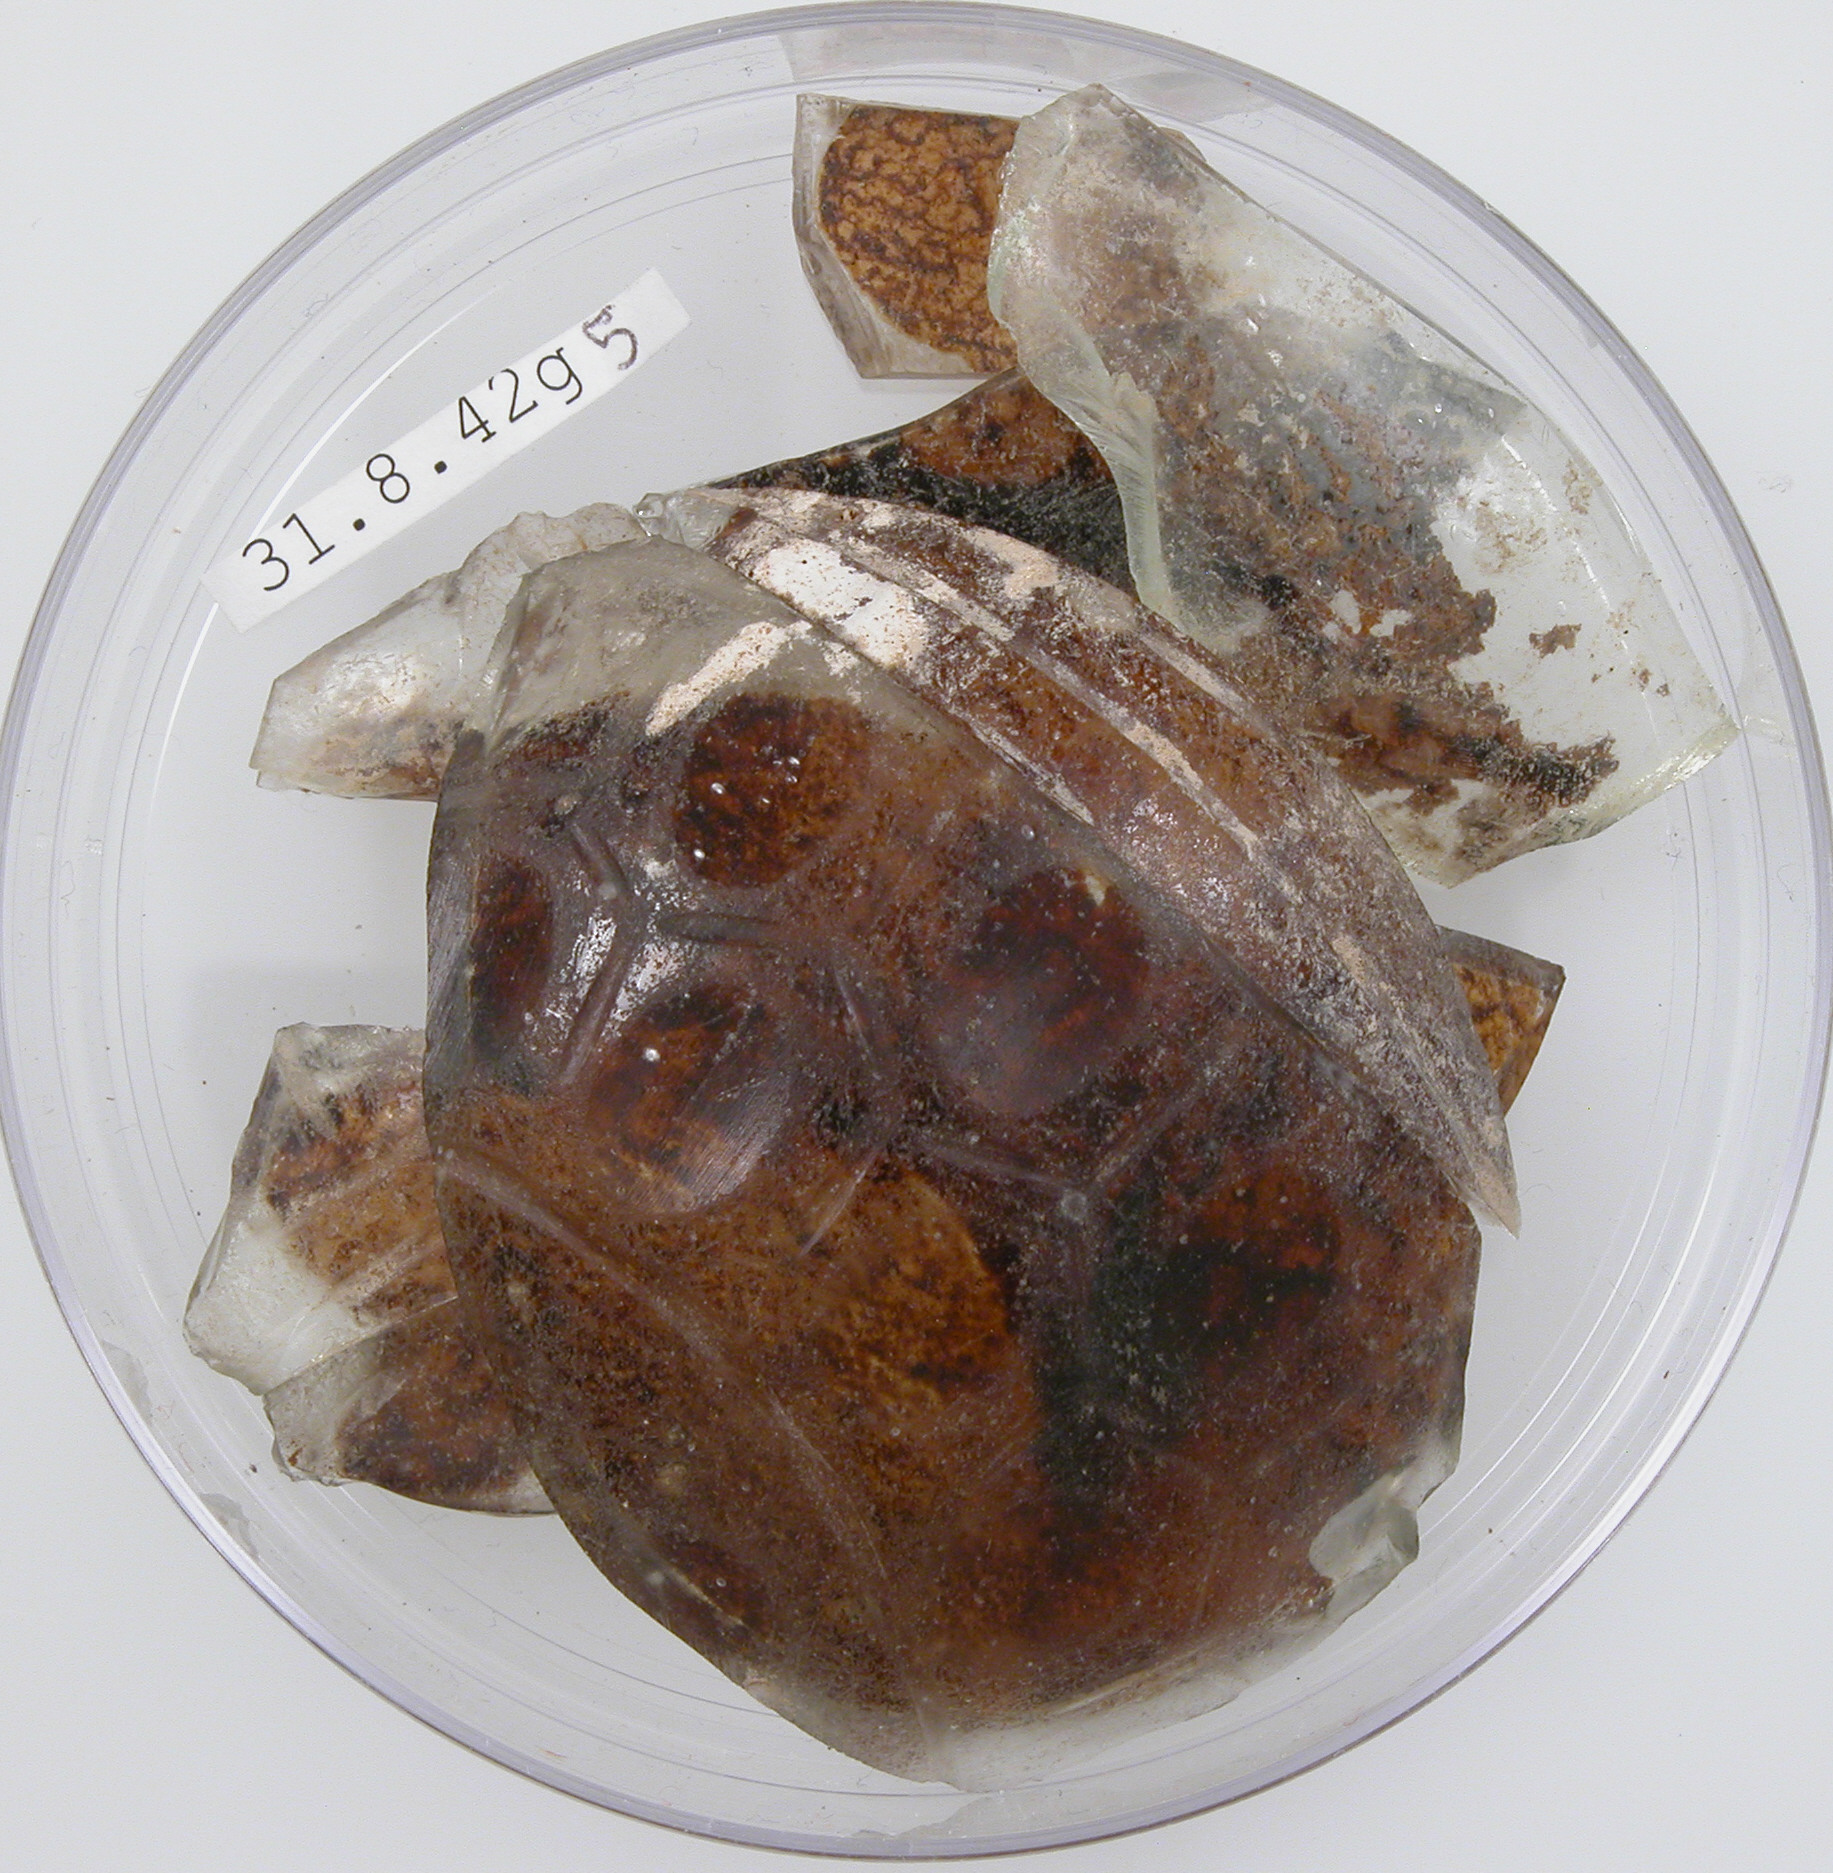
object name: fragment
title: Glass Fragments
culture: coptic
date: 301-400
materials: glass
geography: egypt